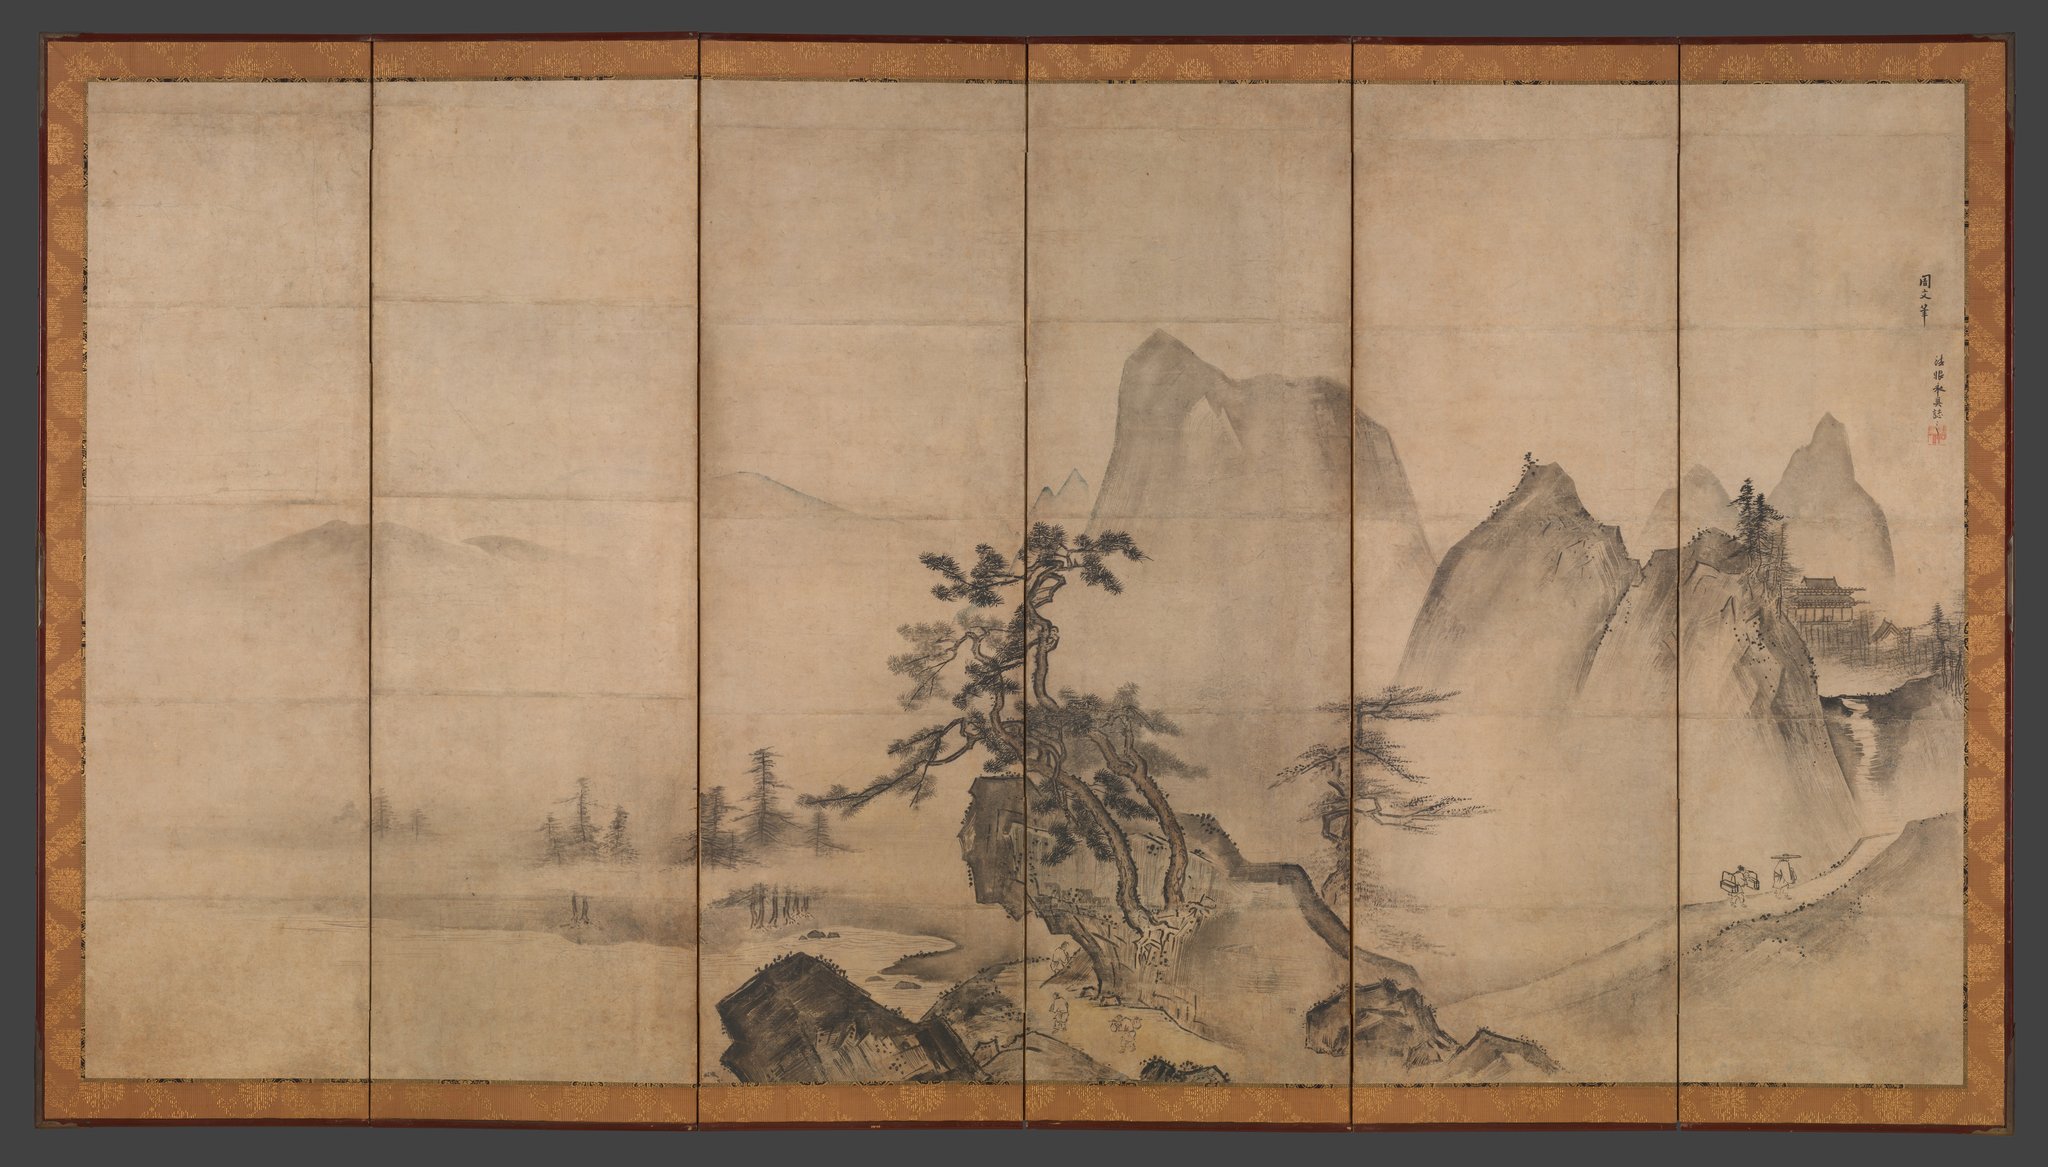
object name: screen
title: Mountain Landscape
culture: japanese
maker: tenshō shūbun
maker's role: artist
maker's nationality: japanese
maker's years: 1414-1463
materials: ink, panel, paper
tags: mountains,landscapes,trees